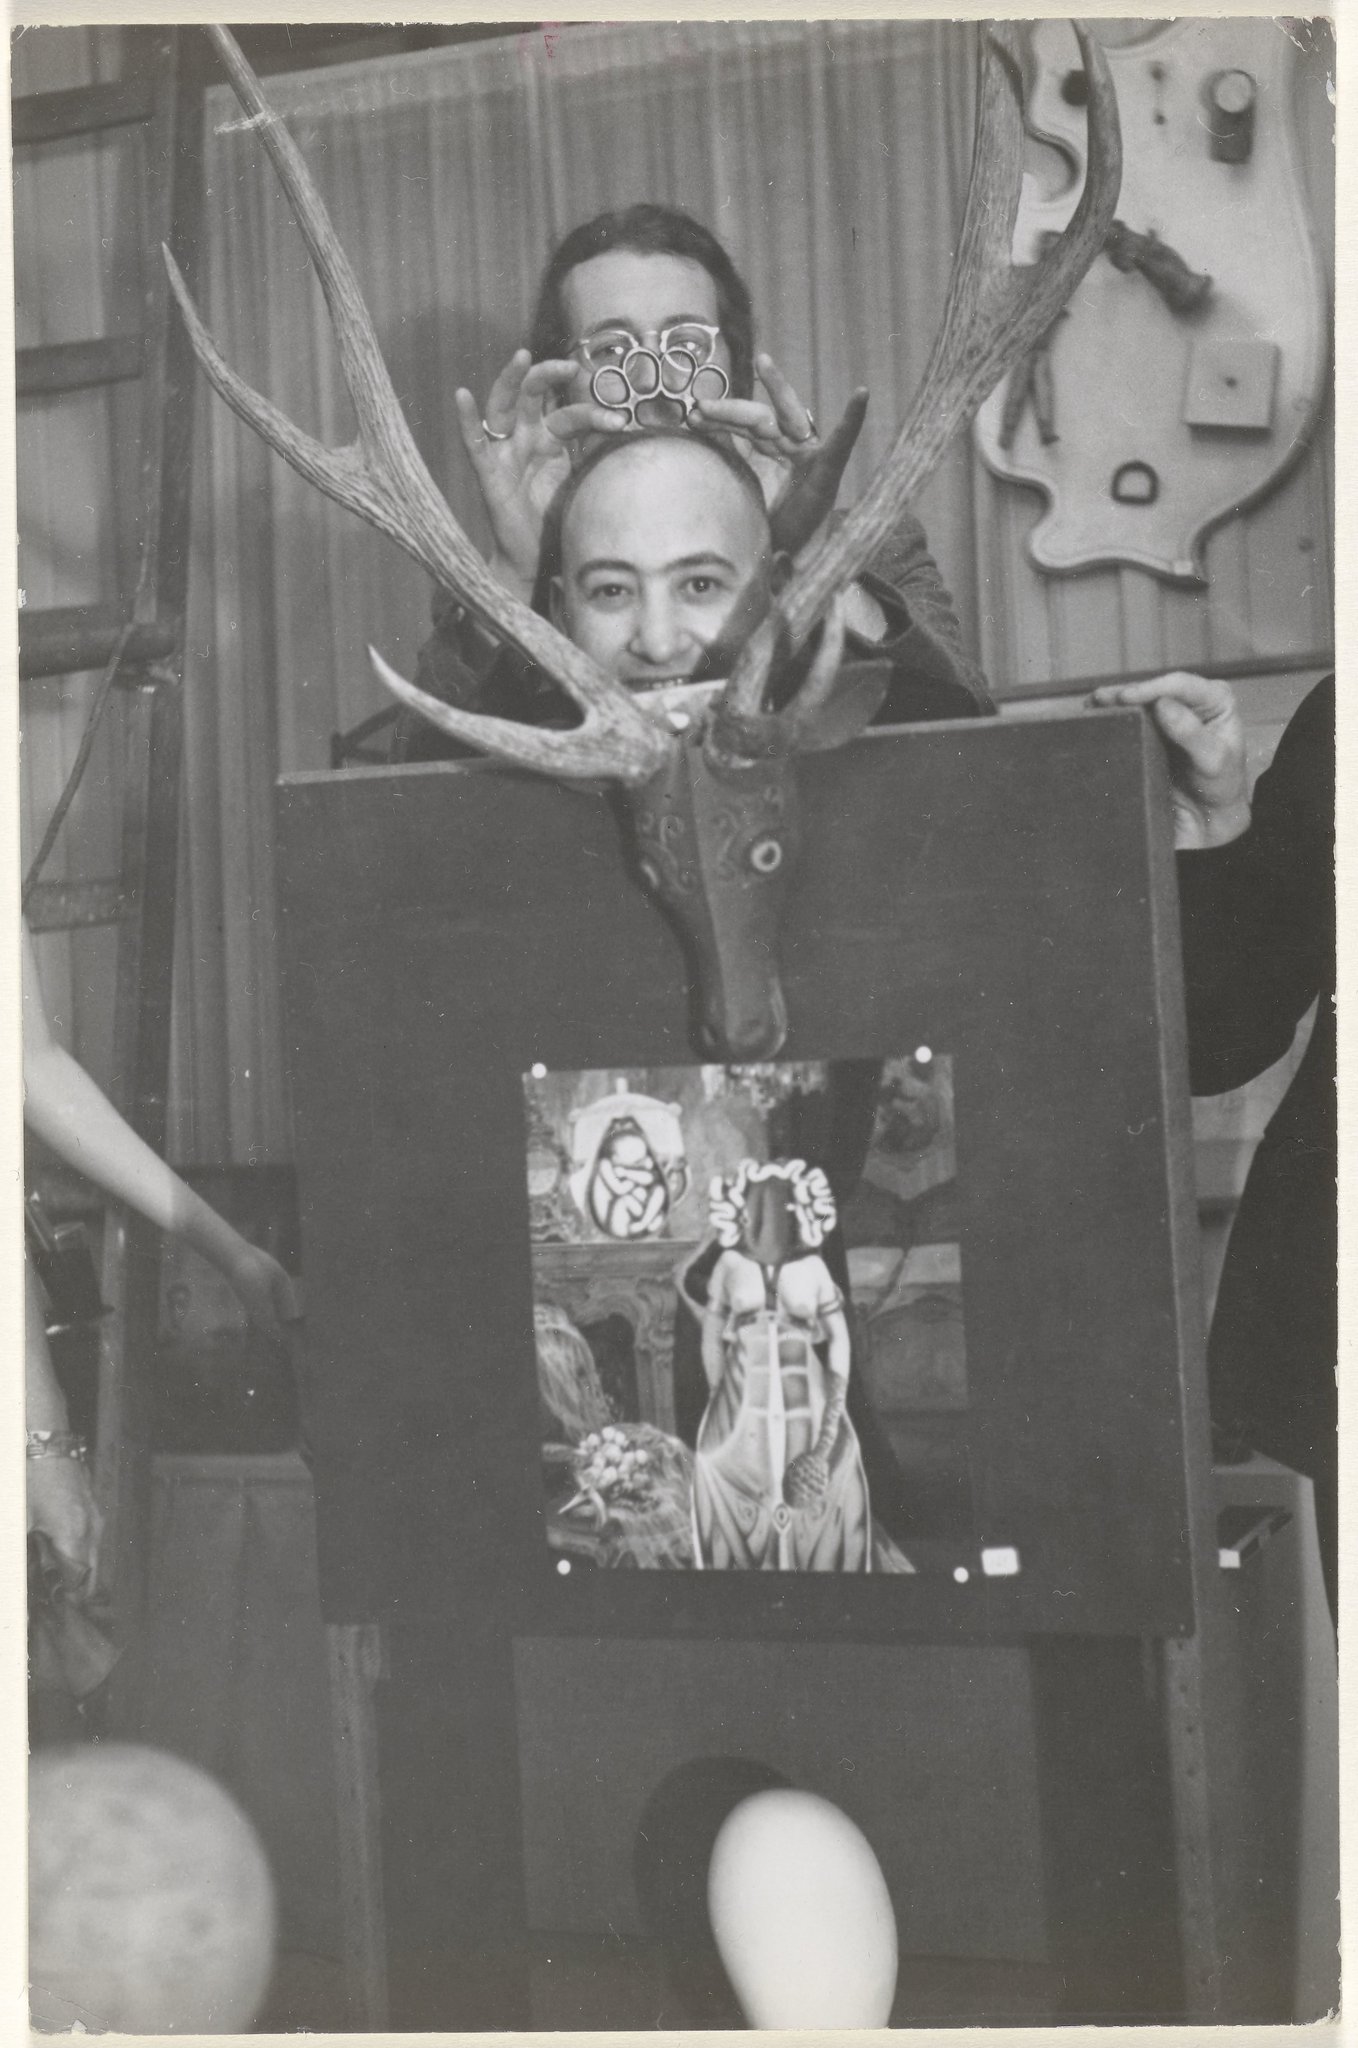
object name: photograph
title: Performance met gewei (Leo Braat) en schilderij surrealisme tentoonstelling Galerie Robert Amsterdam 1938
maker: lilly samuel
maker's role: fotograaf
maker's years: 1909-1944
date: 1938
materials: photographic support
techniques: gelatin silver print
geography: amsterdam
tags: amsterdam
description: Onderdeel van een serie betreffende een reizende tentoonstelling "Exposition Internationale du Surréalisme", in galerie Robert te Amsterdam